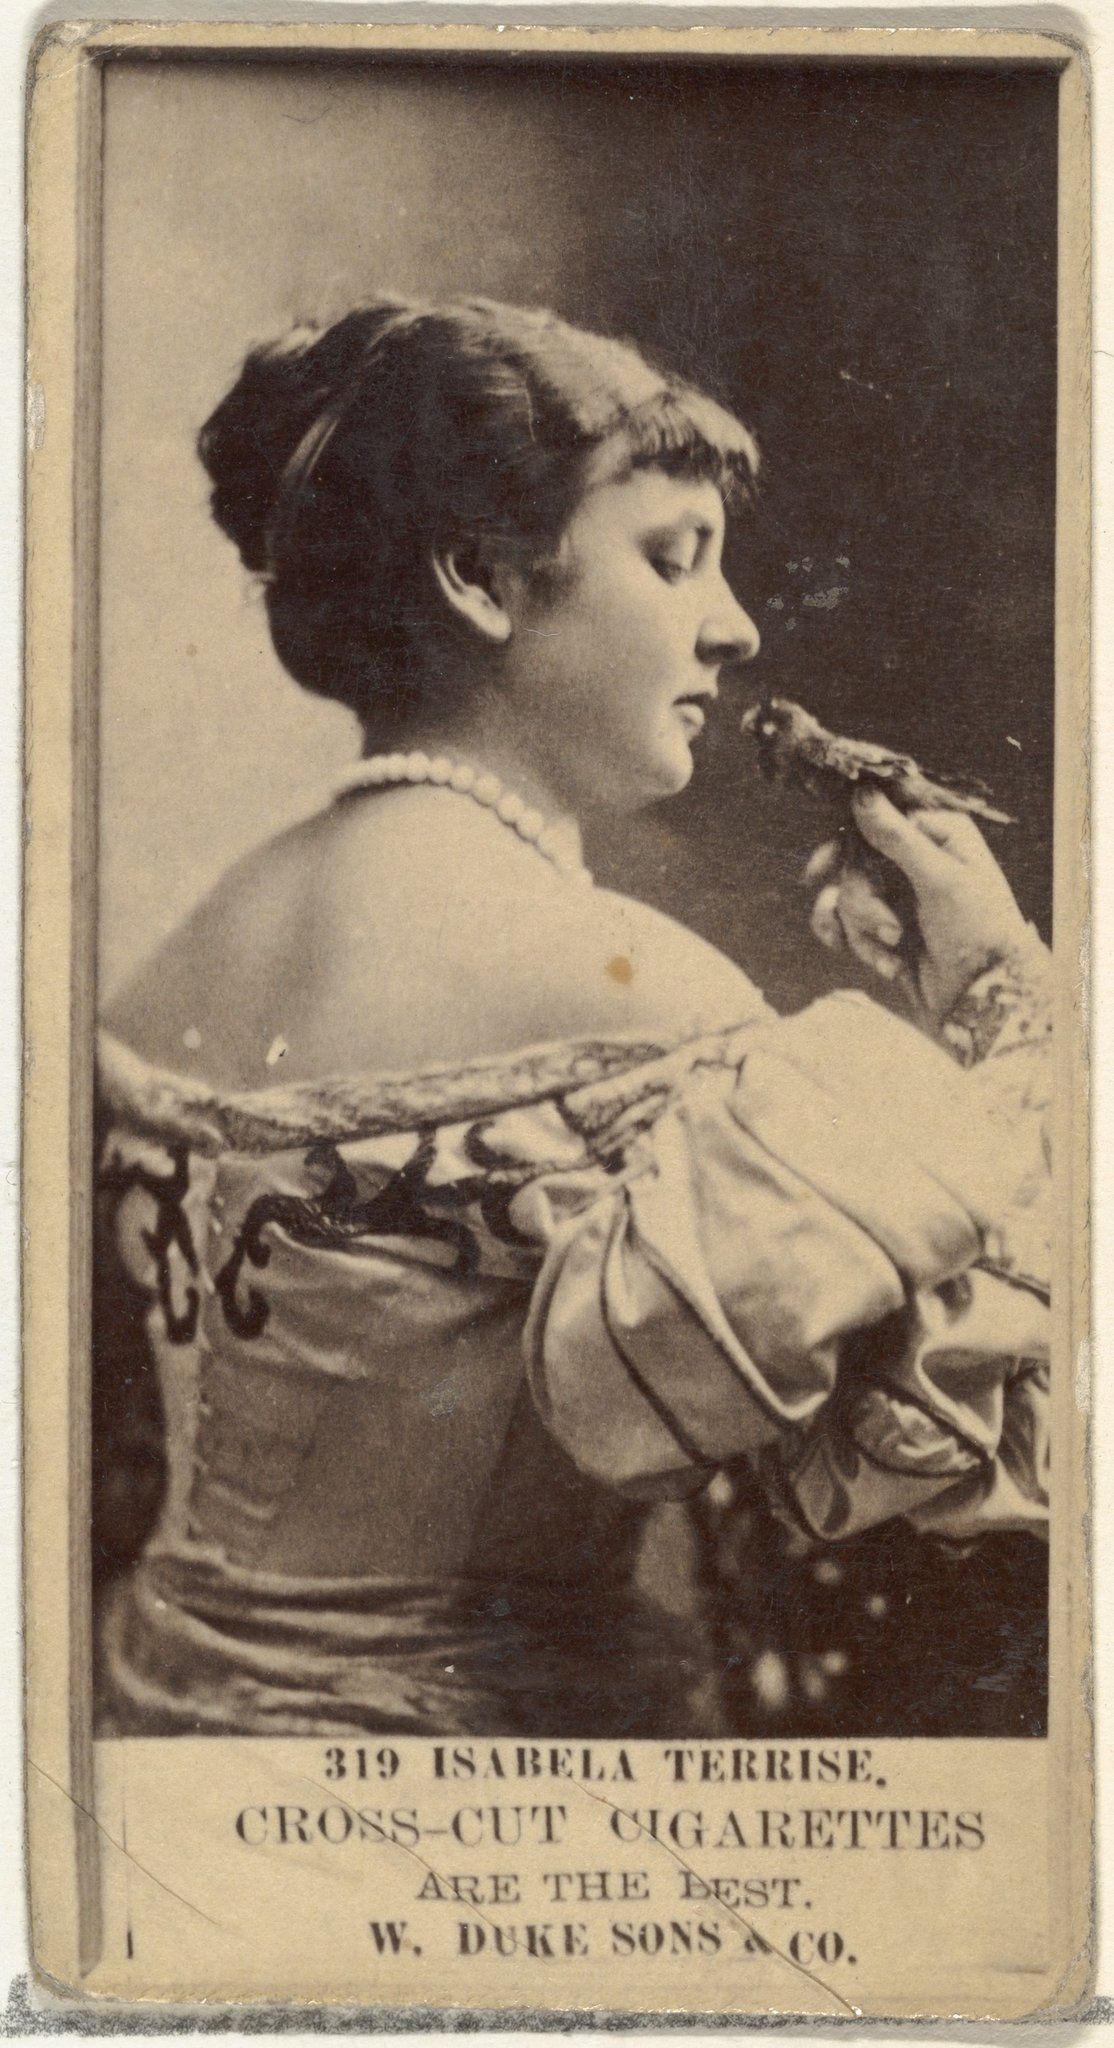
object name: photograph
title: Card Number 319, Isabella Terrise, from the Actors and Actresses series (N145-3) issued by Duke Sons & Co. to promote Cross Cut Cigarettes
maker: w. duke, sons & co.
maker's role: publisher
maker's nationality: american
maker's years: 1870-1920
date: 1880-1889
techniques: albumen silver print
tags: women,actresses